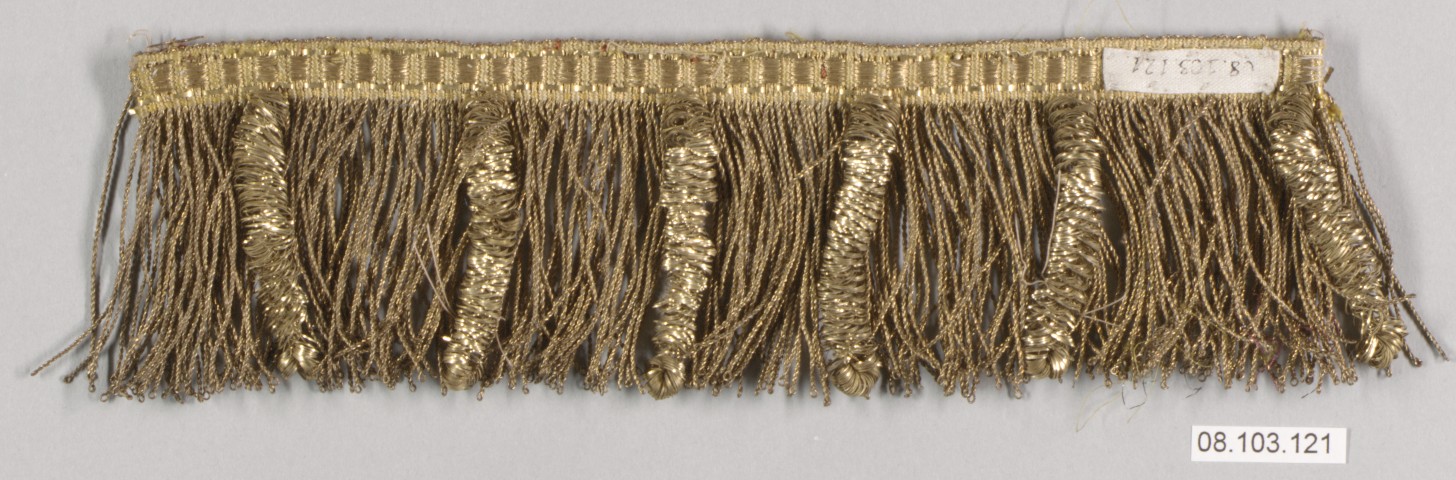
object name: fringe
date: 1801-1900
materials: metal thread